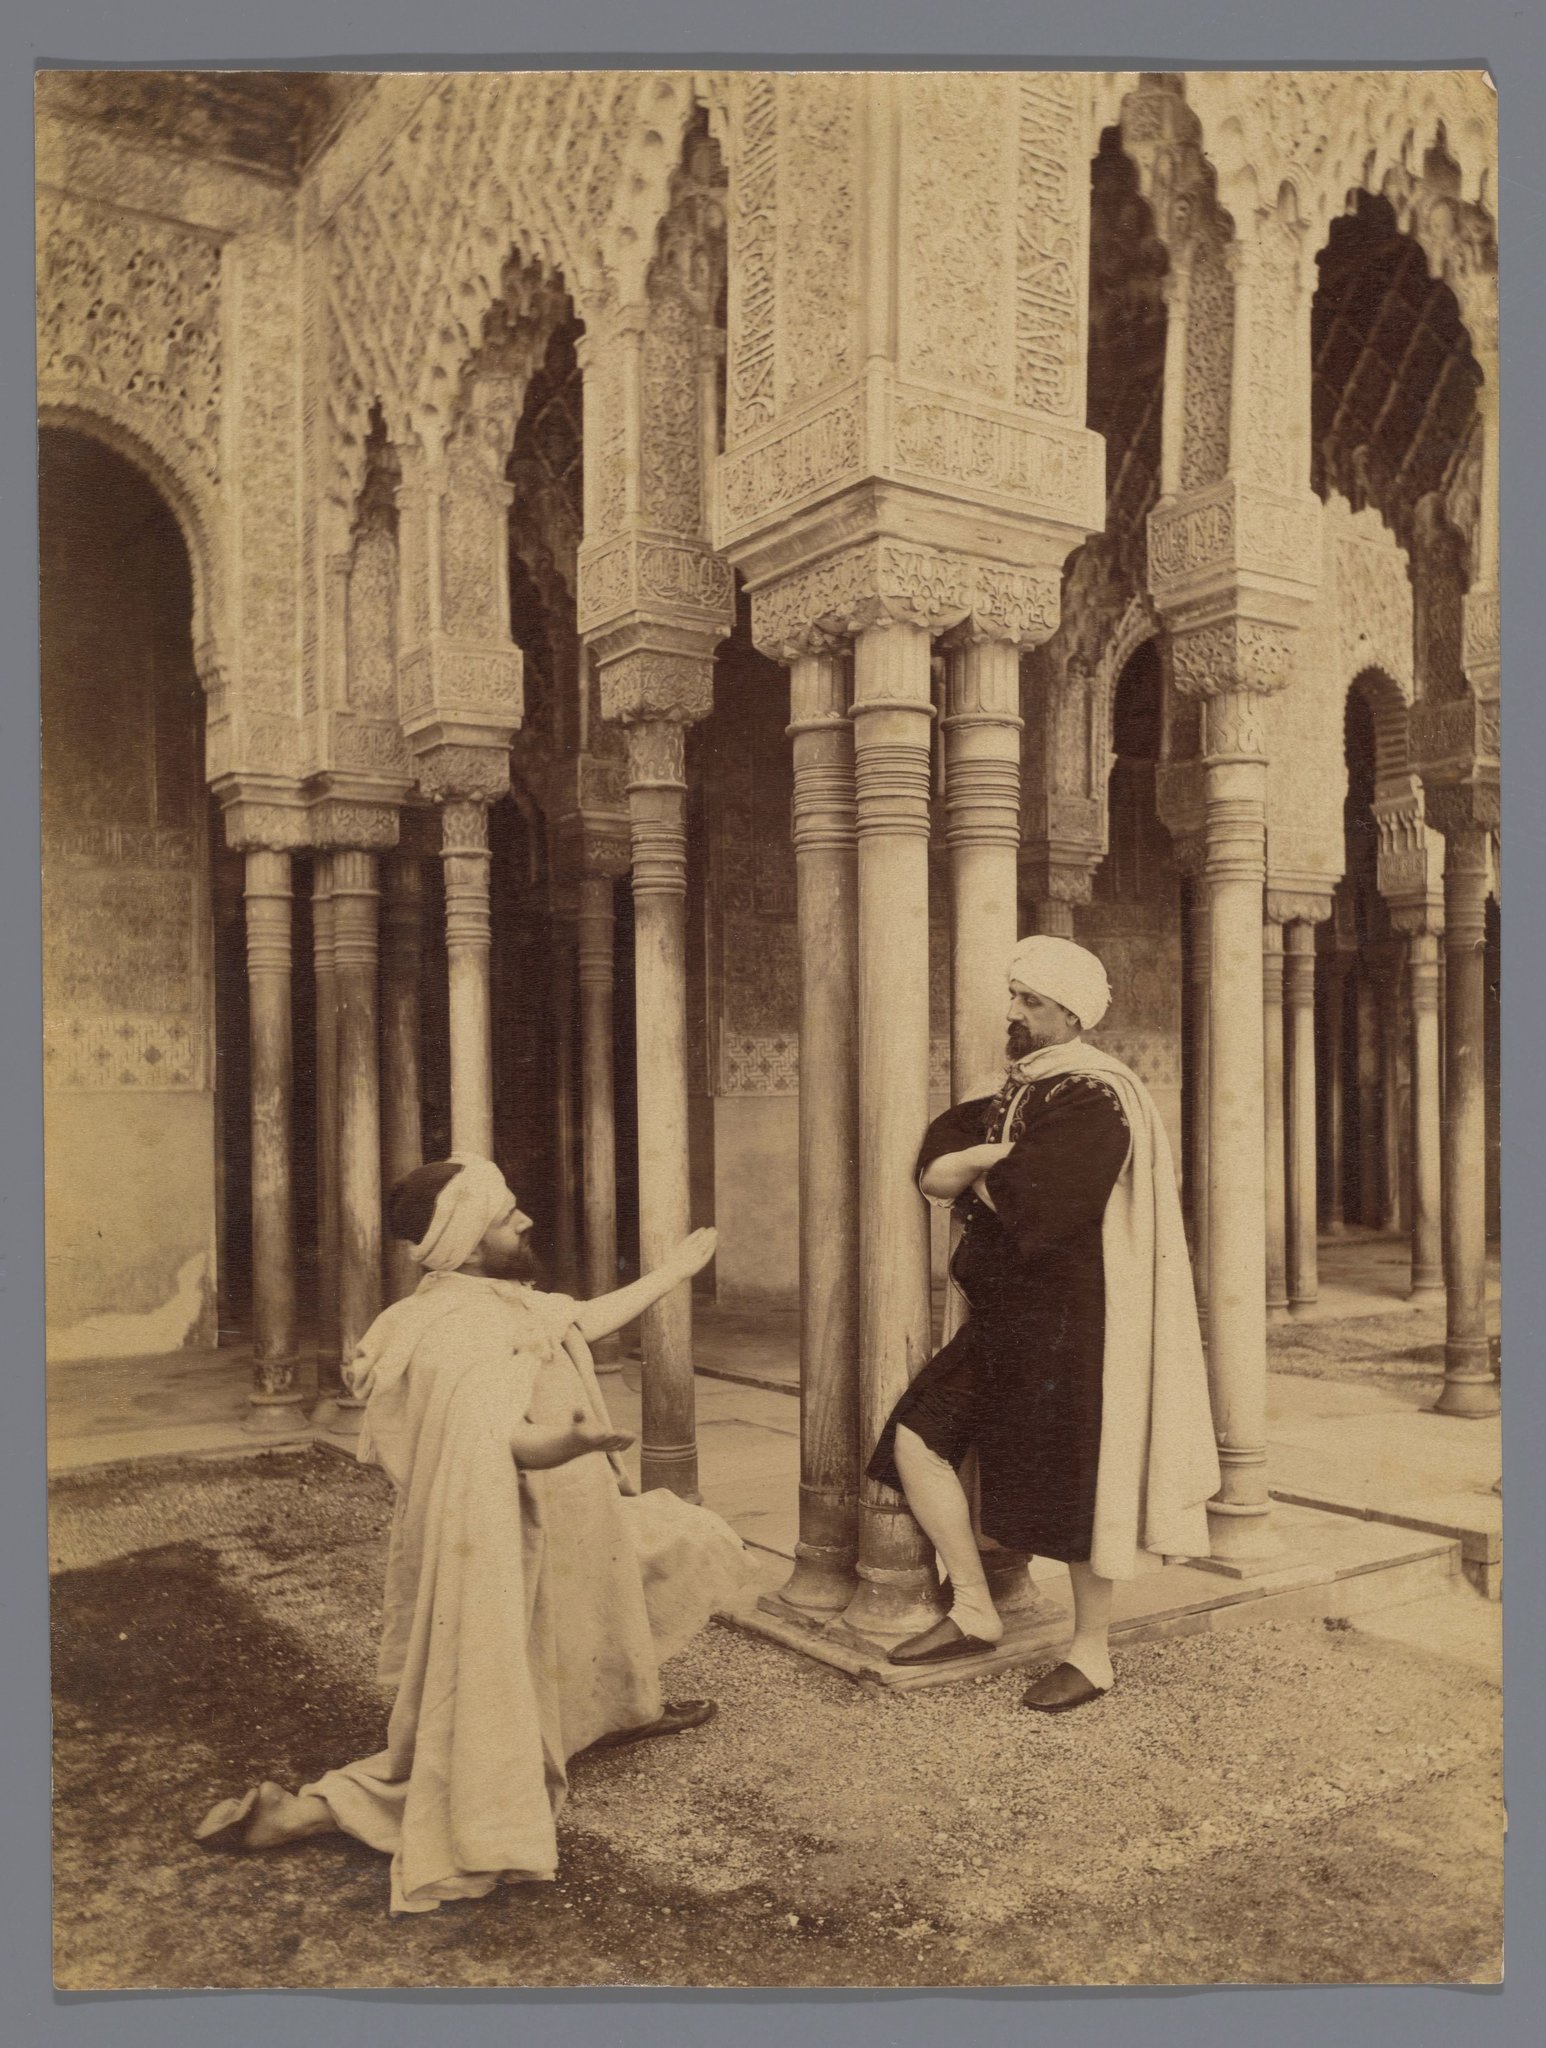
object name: photograph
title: Geënsceneerde voorstelling met twee onbekende mannen in het Alhambra van Granada, een van hen knielt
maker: Anonymous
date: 1860-1900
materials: paper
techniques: albumen print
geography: granada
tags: anonymous historical persons portrayed in a double portrait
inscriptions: inscription: ‘Granada.’